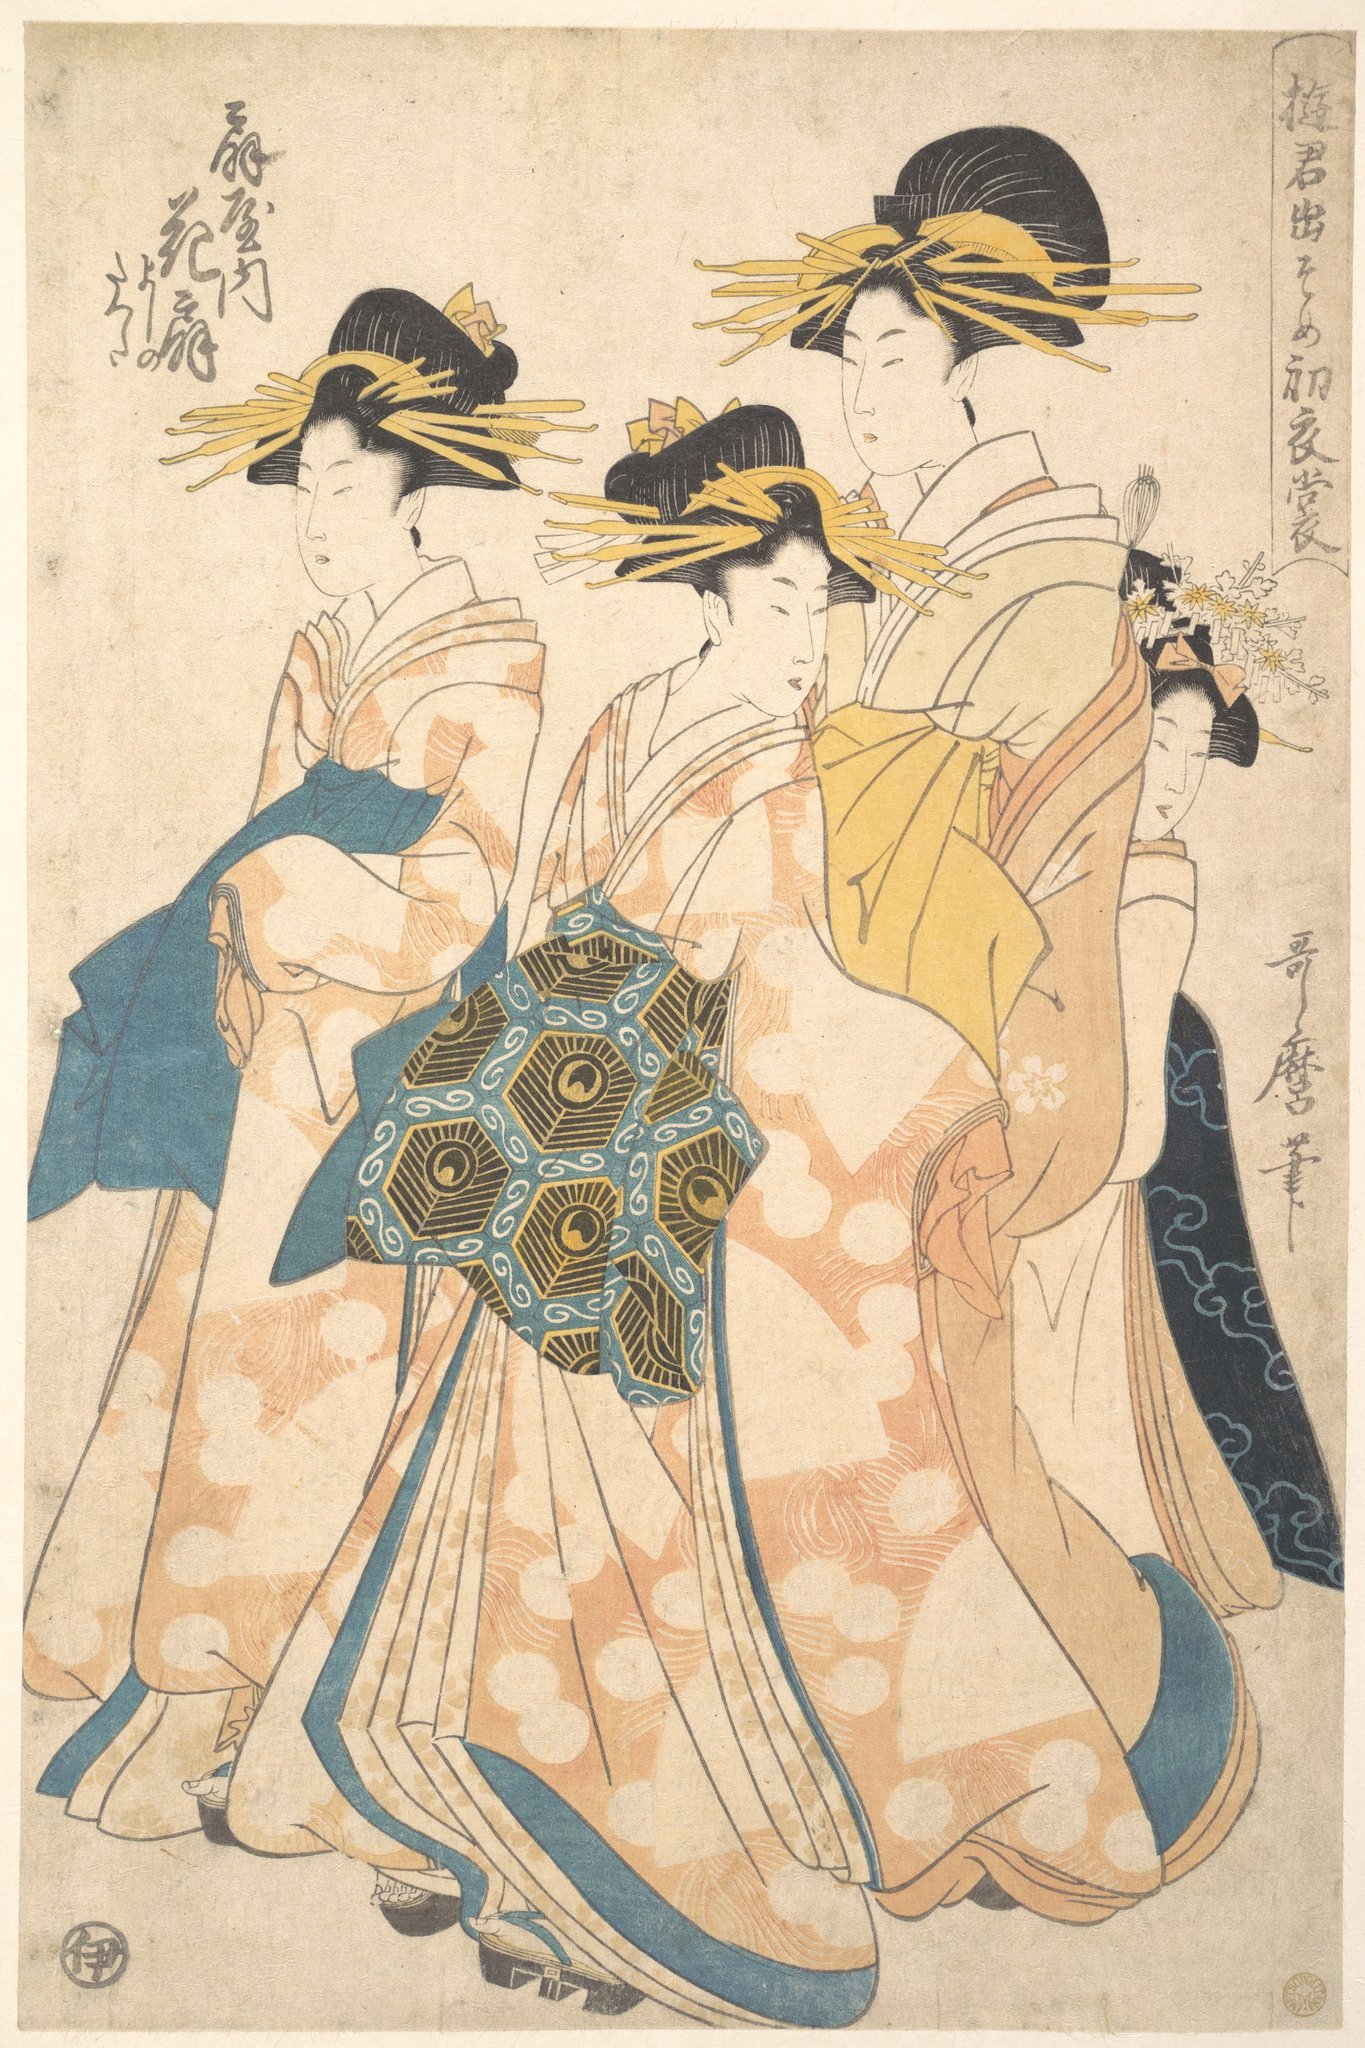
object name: print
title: The Oiran Hanaogi of Ogiya attended by Two Shinzo and Her Kamuro Yoshino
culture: japanese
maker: utamaro ii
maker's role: artist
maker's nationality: japanese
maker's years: 1750-1850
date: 1806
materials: ink, paper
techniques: woodblock print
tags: women